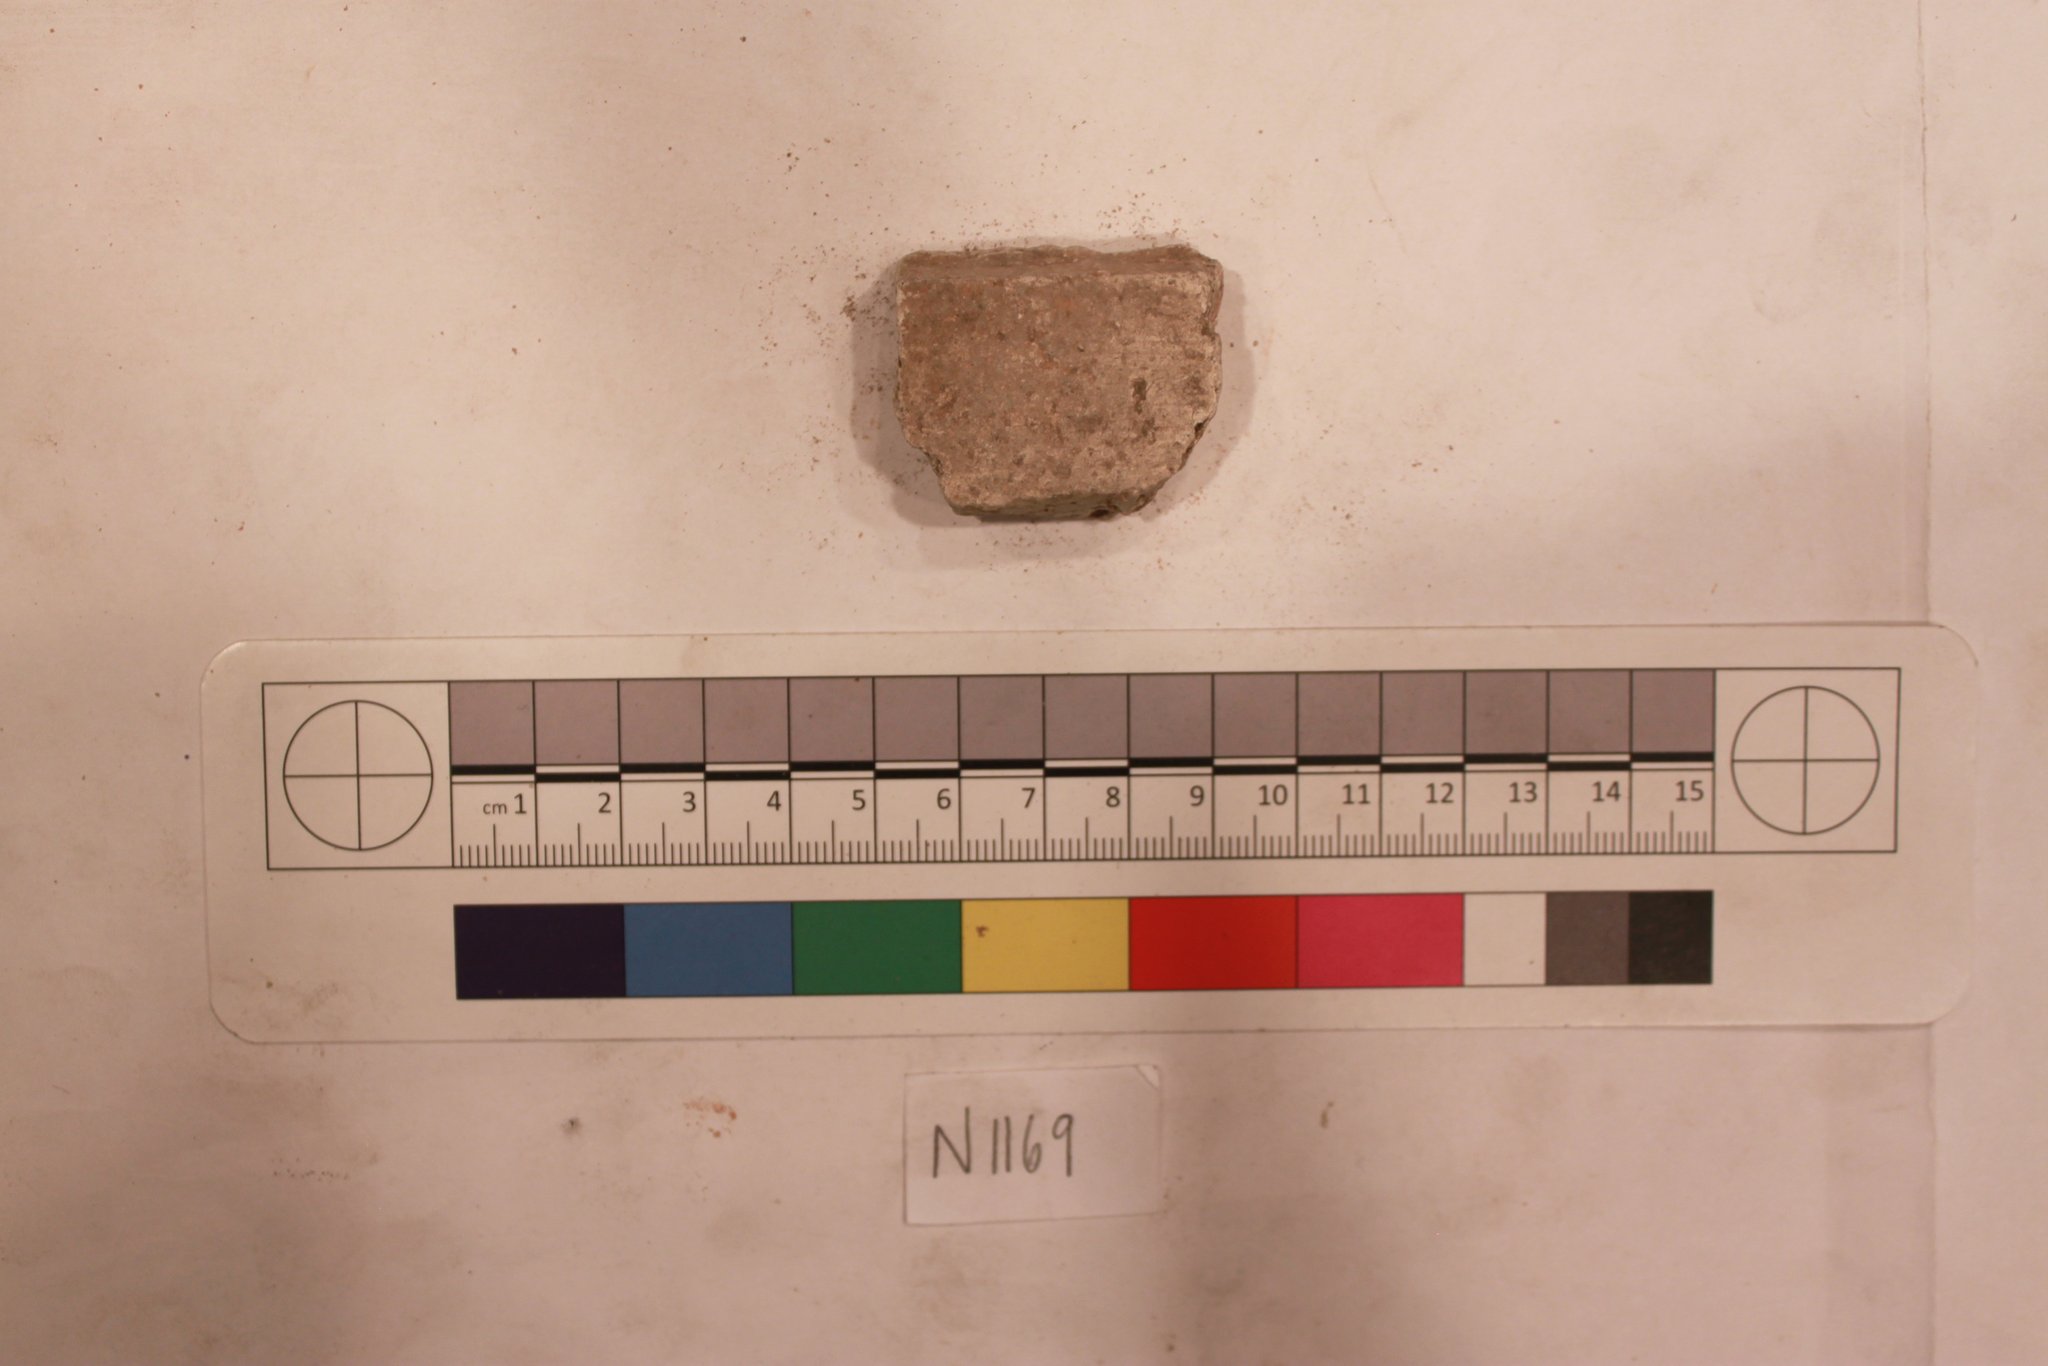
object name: fragment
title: Stucco Fragment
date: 701-1200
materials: plaster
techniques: carving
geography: iran